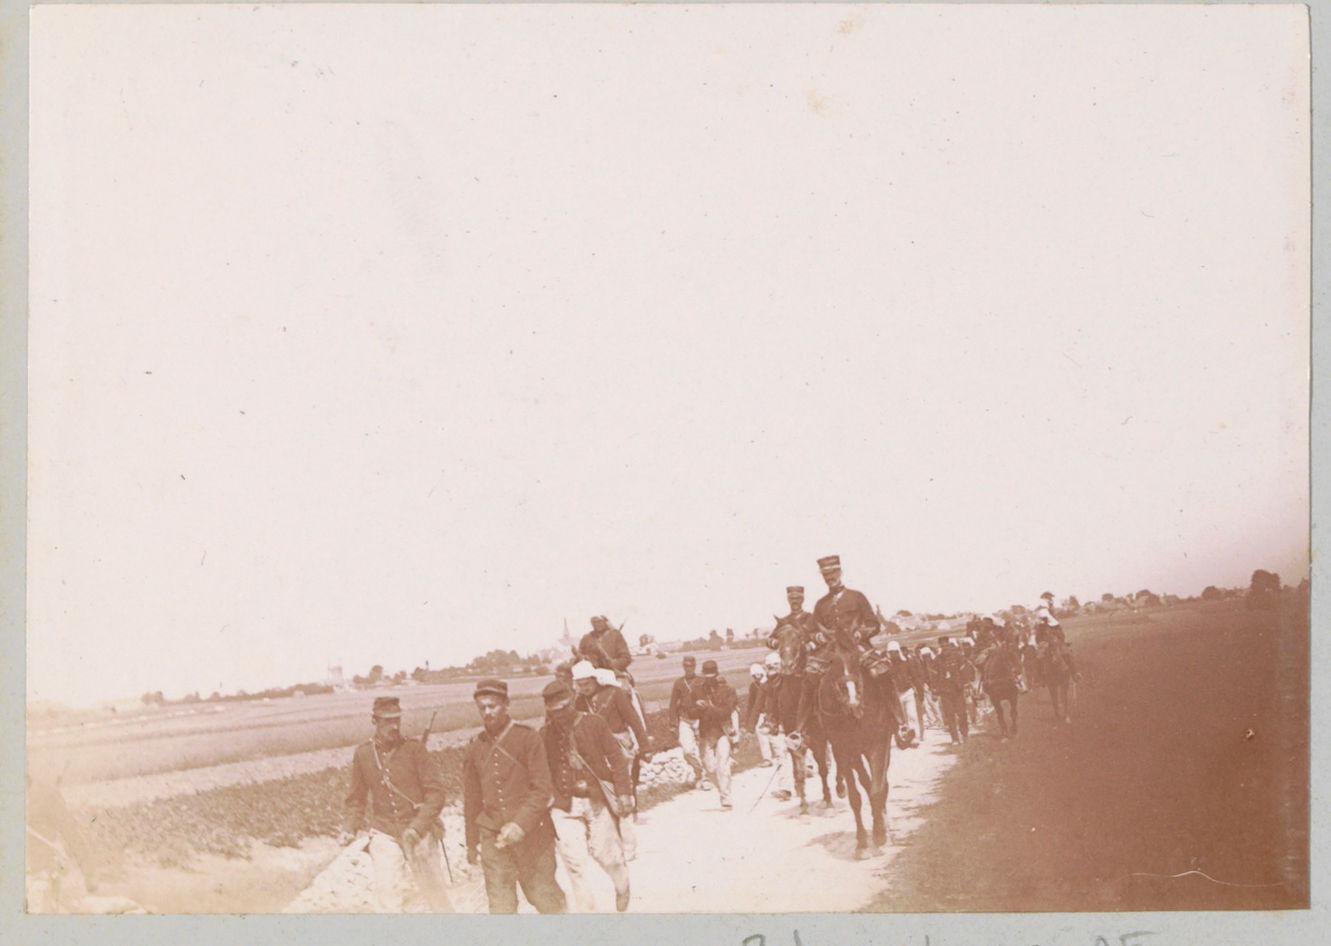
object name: photograph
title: Militairen te paard en te voet op een landweg in Frankrijk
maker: delizy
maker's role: manufacturer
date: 1896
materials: paper, photographic support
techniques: gelatin silver print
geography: france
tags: land forces (+ cavalry, horsemen), road, path, france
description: Onderdeel van Fotoalbum van een Franse amateurfotograaf met opnames van uitstapjes in Frankrijk, Spanje, België, Luxemburg en Nederland, de eerste automobielen en autoraces.